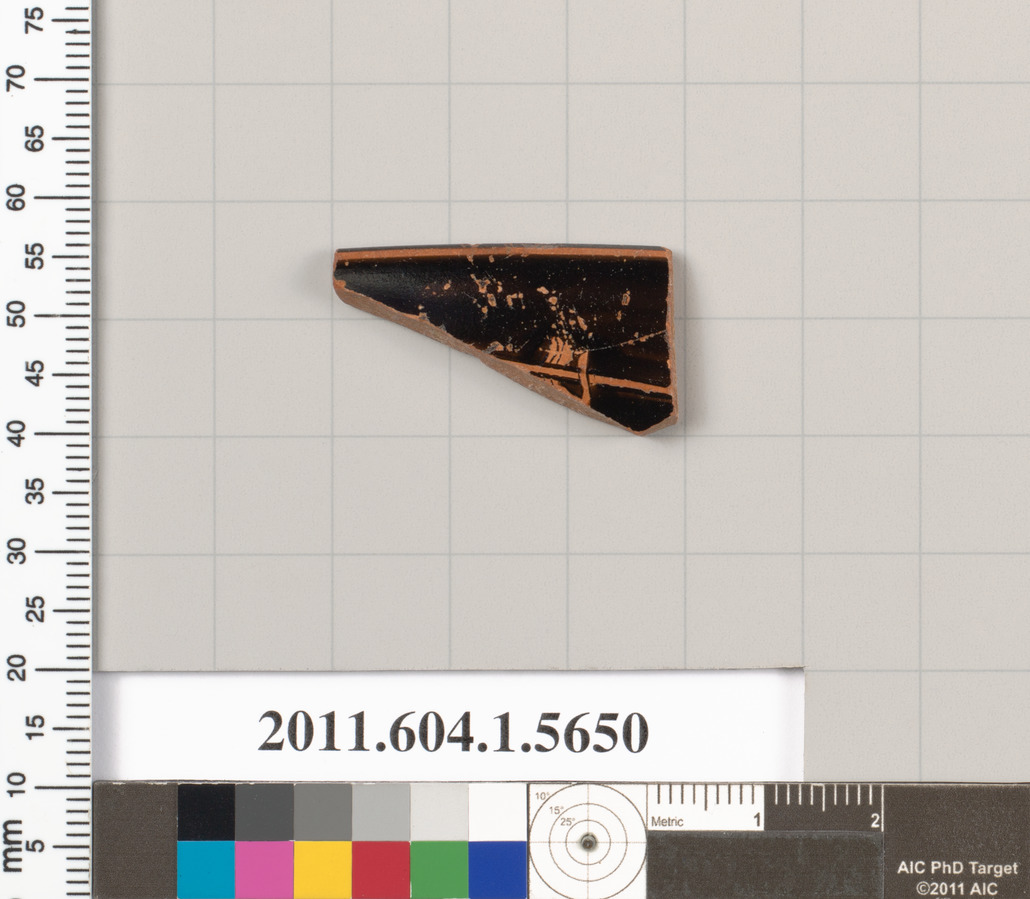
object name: kylix fragment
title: Terracotta rim fragment of a kylix (drinking cup)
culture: greek, attic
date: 510-480 BCE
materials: terracotta